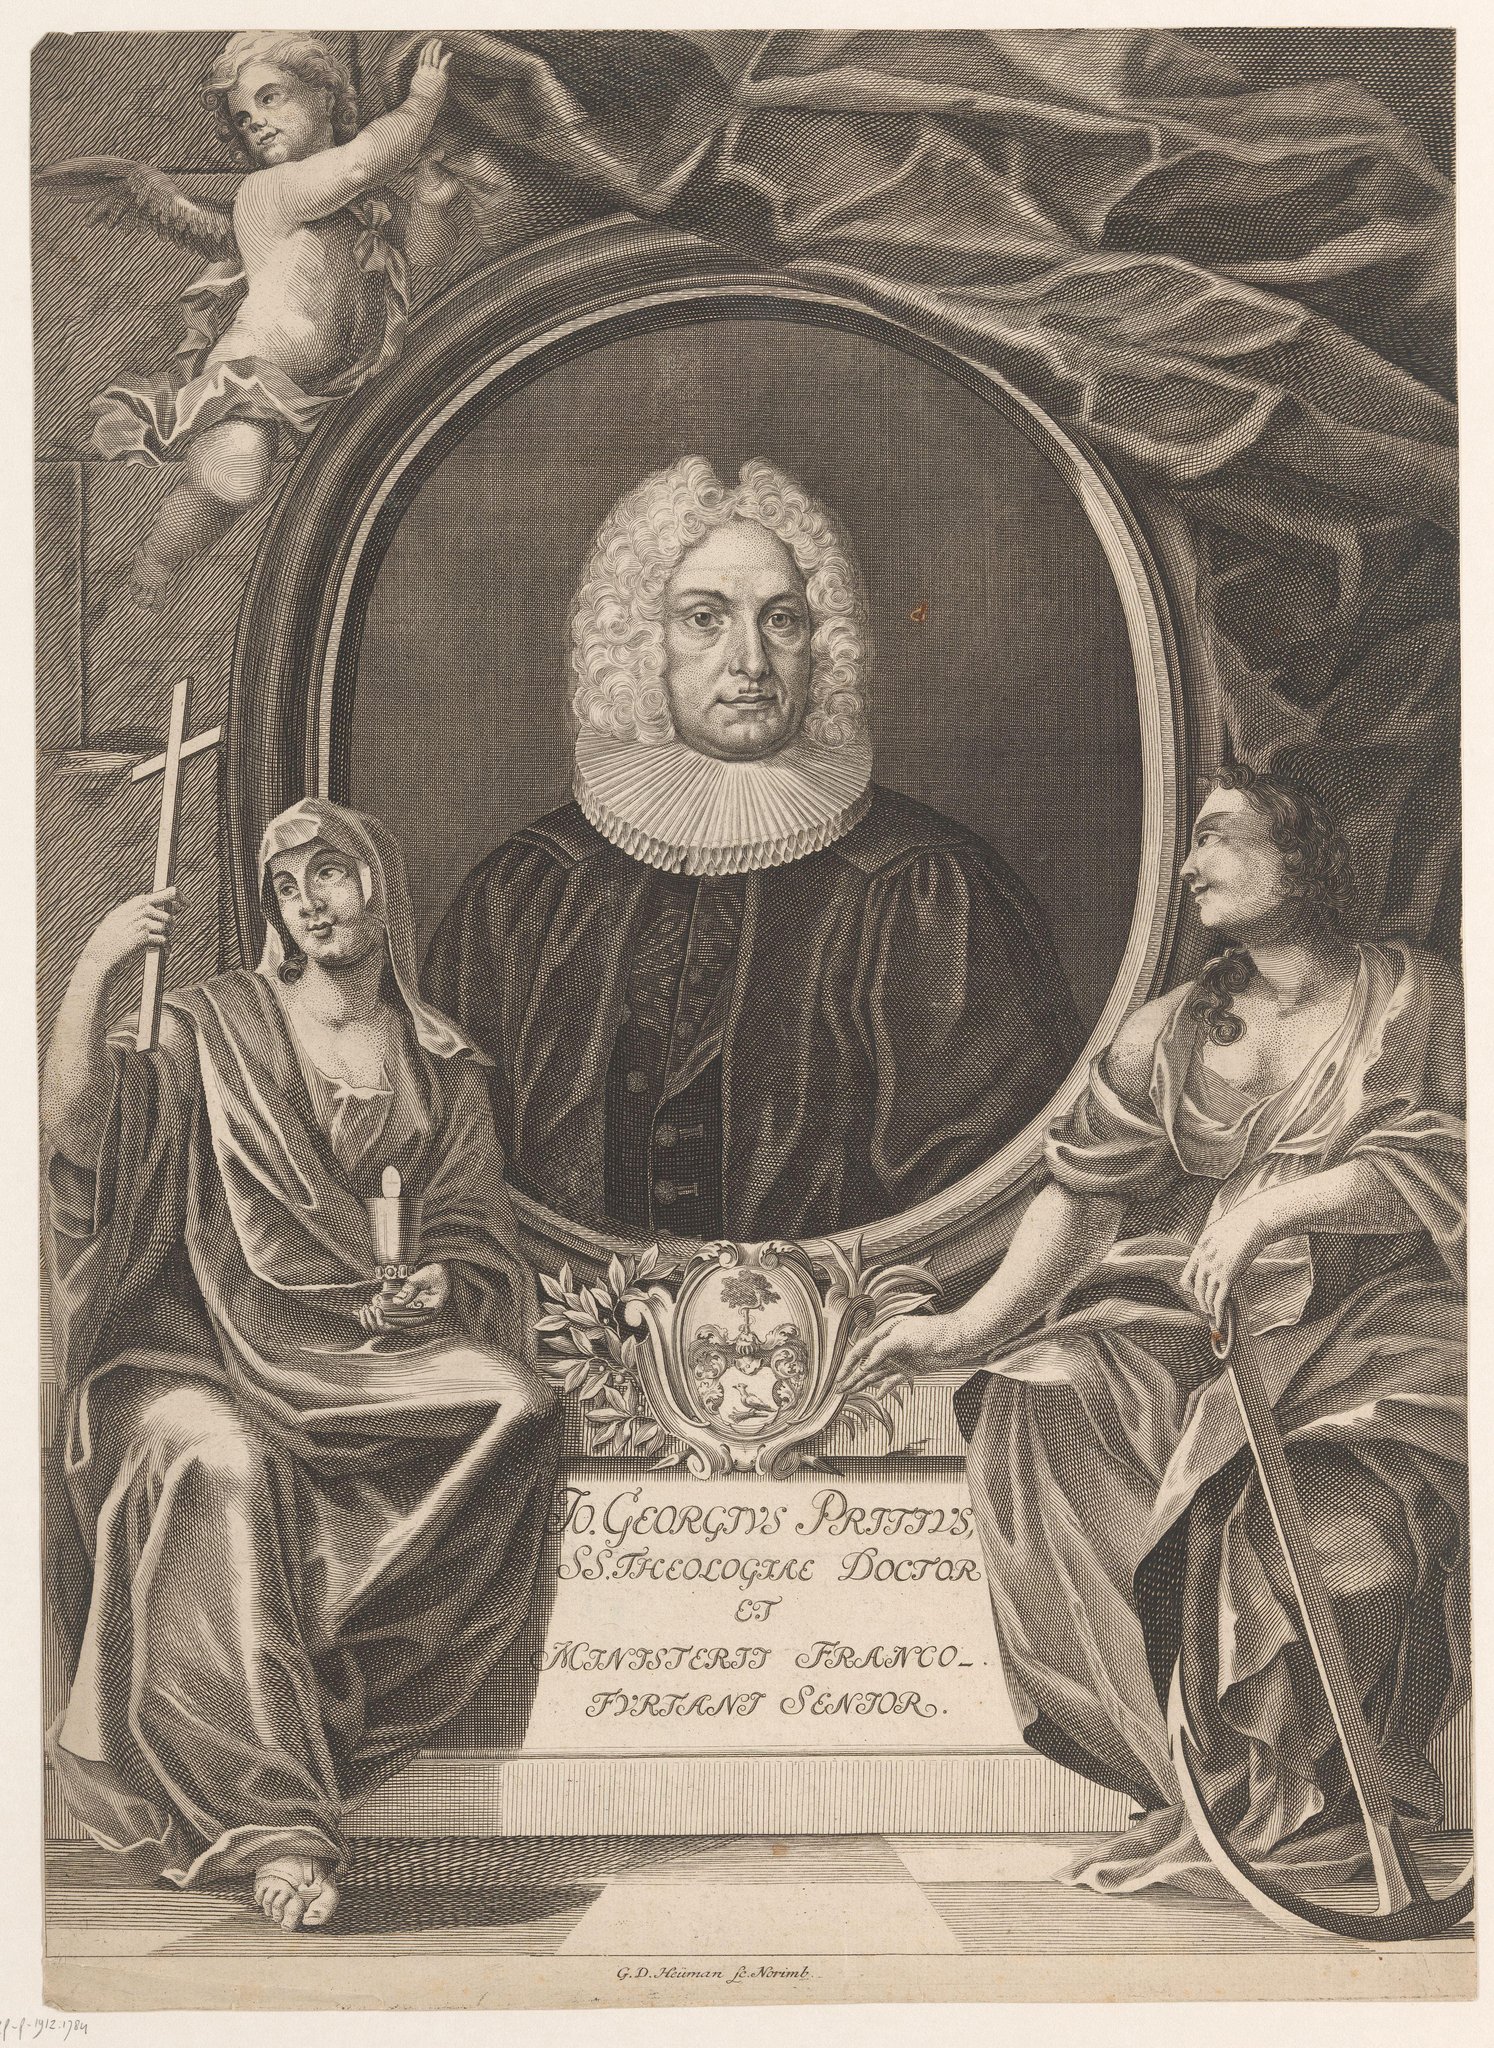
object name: print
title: Portret van Johann Georg Pritius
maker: georg daniel heumann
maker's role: print maker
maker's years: 1691-1759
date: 1701-1759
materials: paper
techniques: engraving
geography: nuremberg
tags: johann georg pritius, abstract ideas and concepts (+ allegorical scene, i.e. two or more personifications involved in an action), historical persons, armorial bearing, heraldry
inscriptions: collector's mark: Lugt 2228